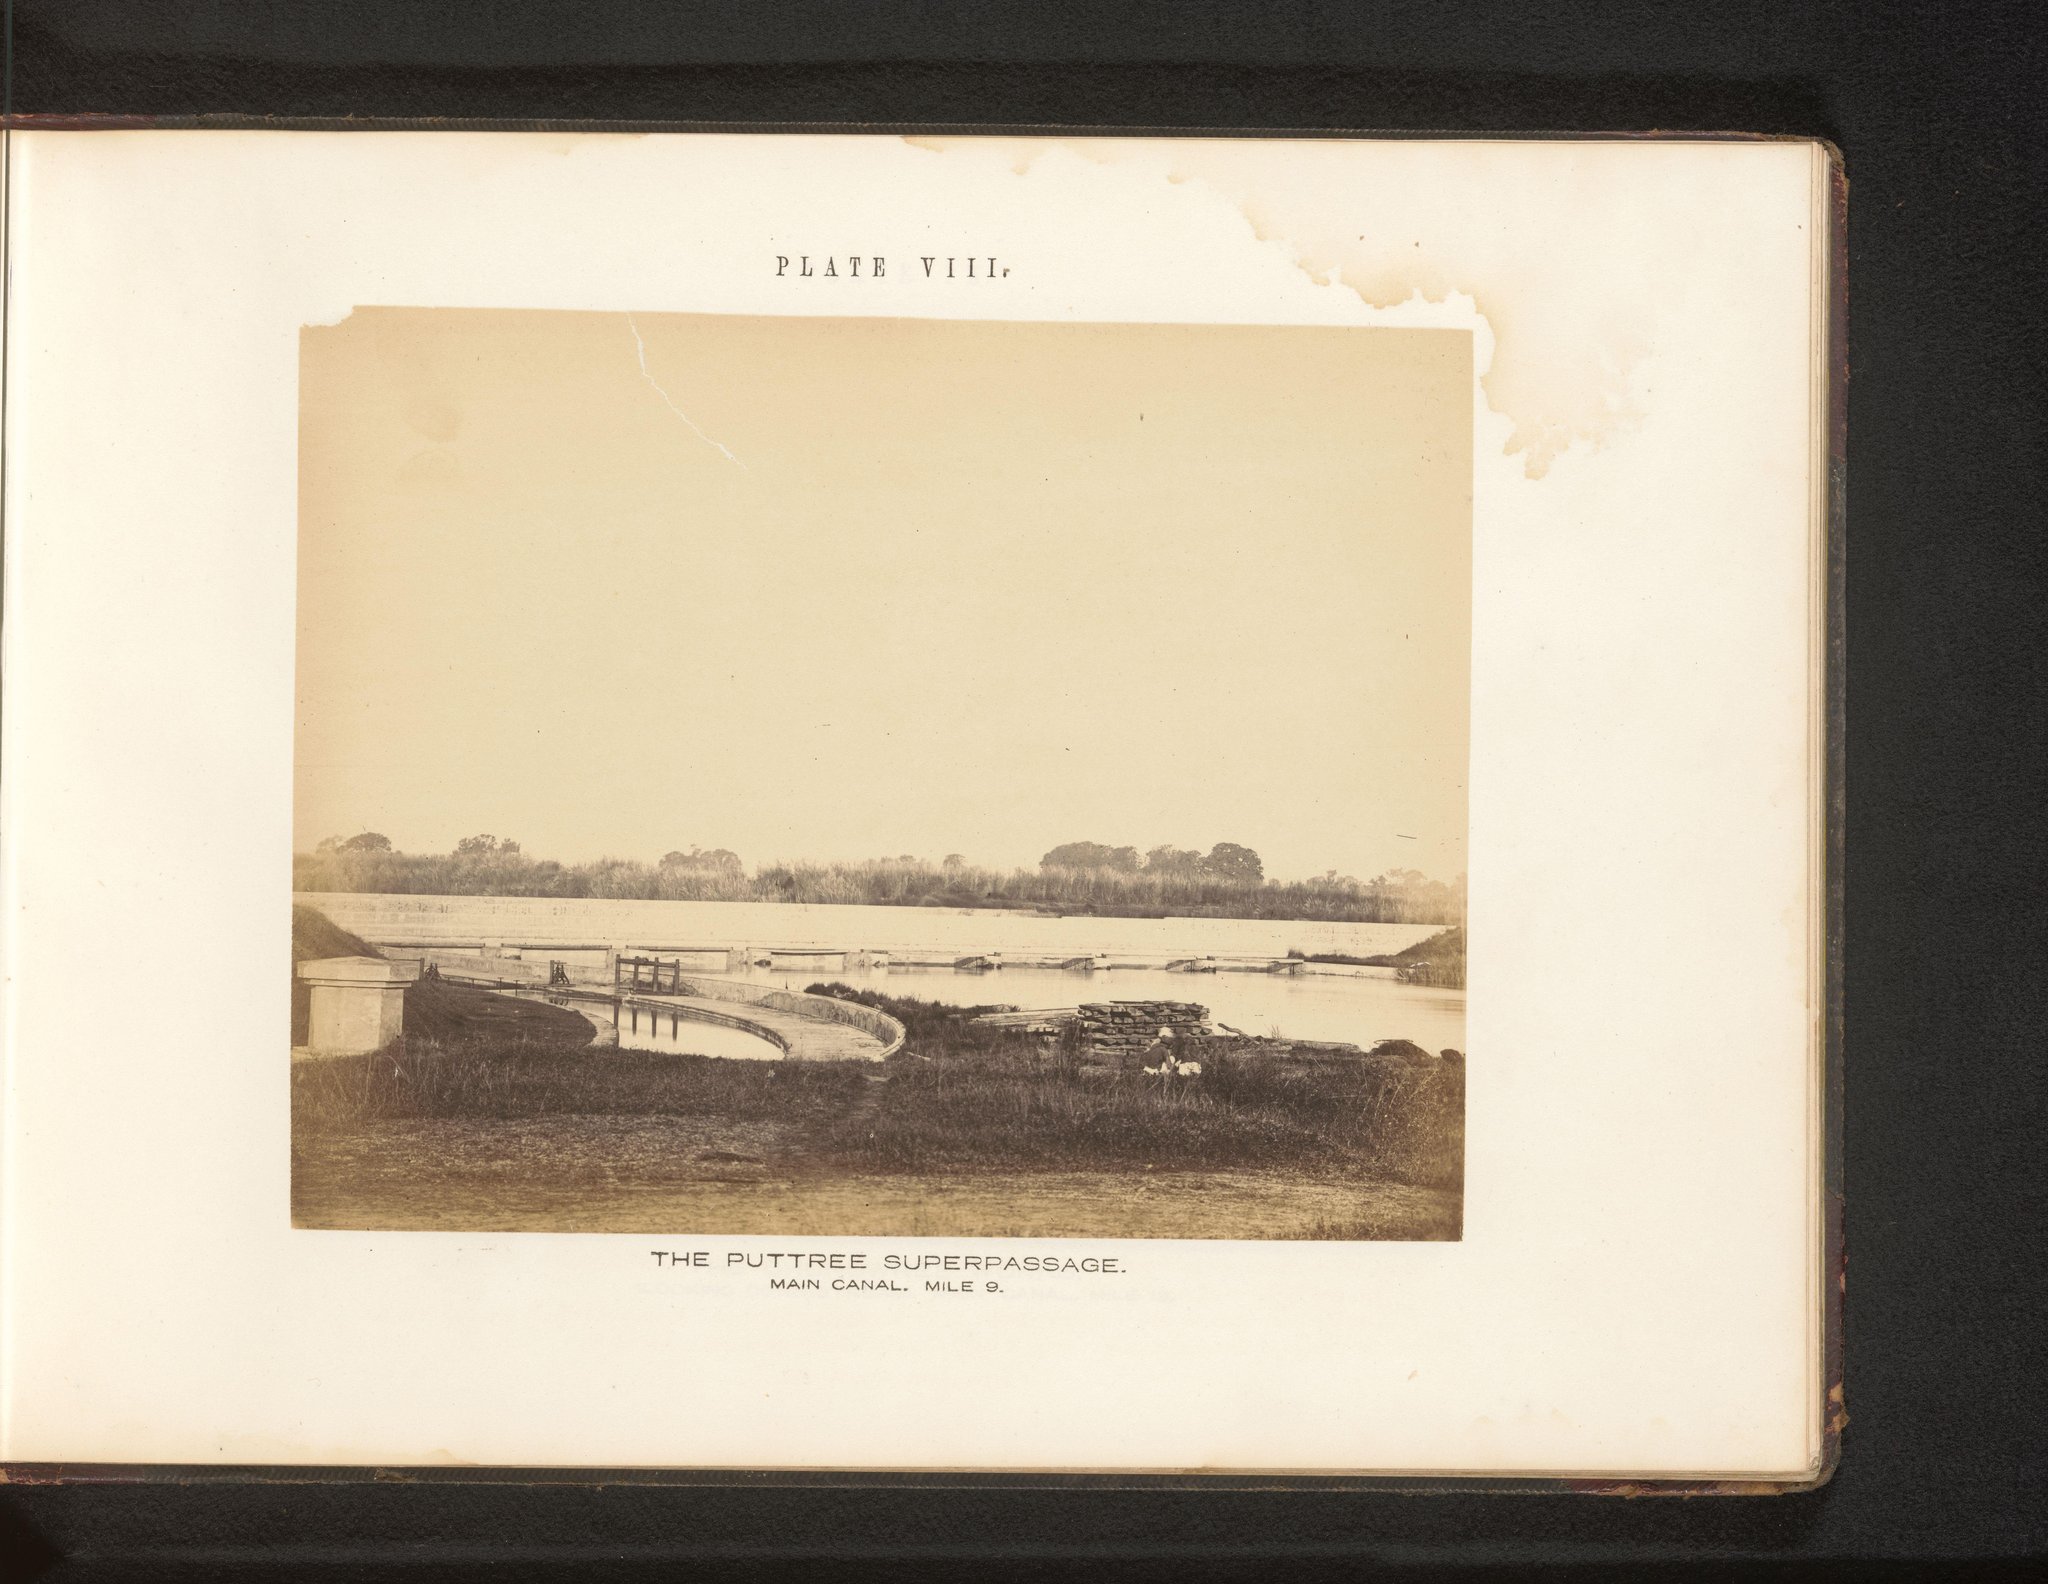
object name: page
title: Gezicht op waterwerken in de Ganges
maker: thomas george glover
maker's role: fotograaf, luitenant-kolonel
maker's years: 1825-1881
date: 1862-1867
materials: photographic support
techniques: albumen print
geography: india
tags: river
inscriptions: inscription: ‘main canal. mile 9.’, inscription: ‘Plate VIII’